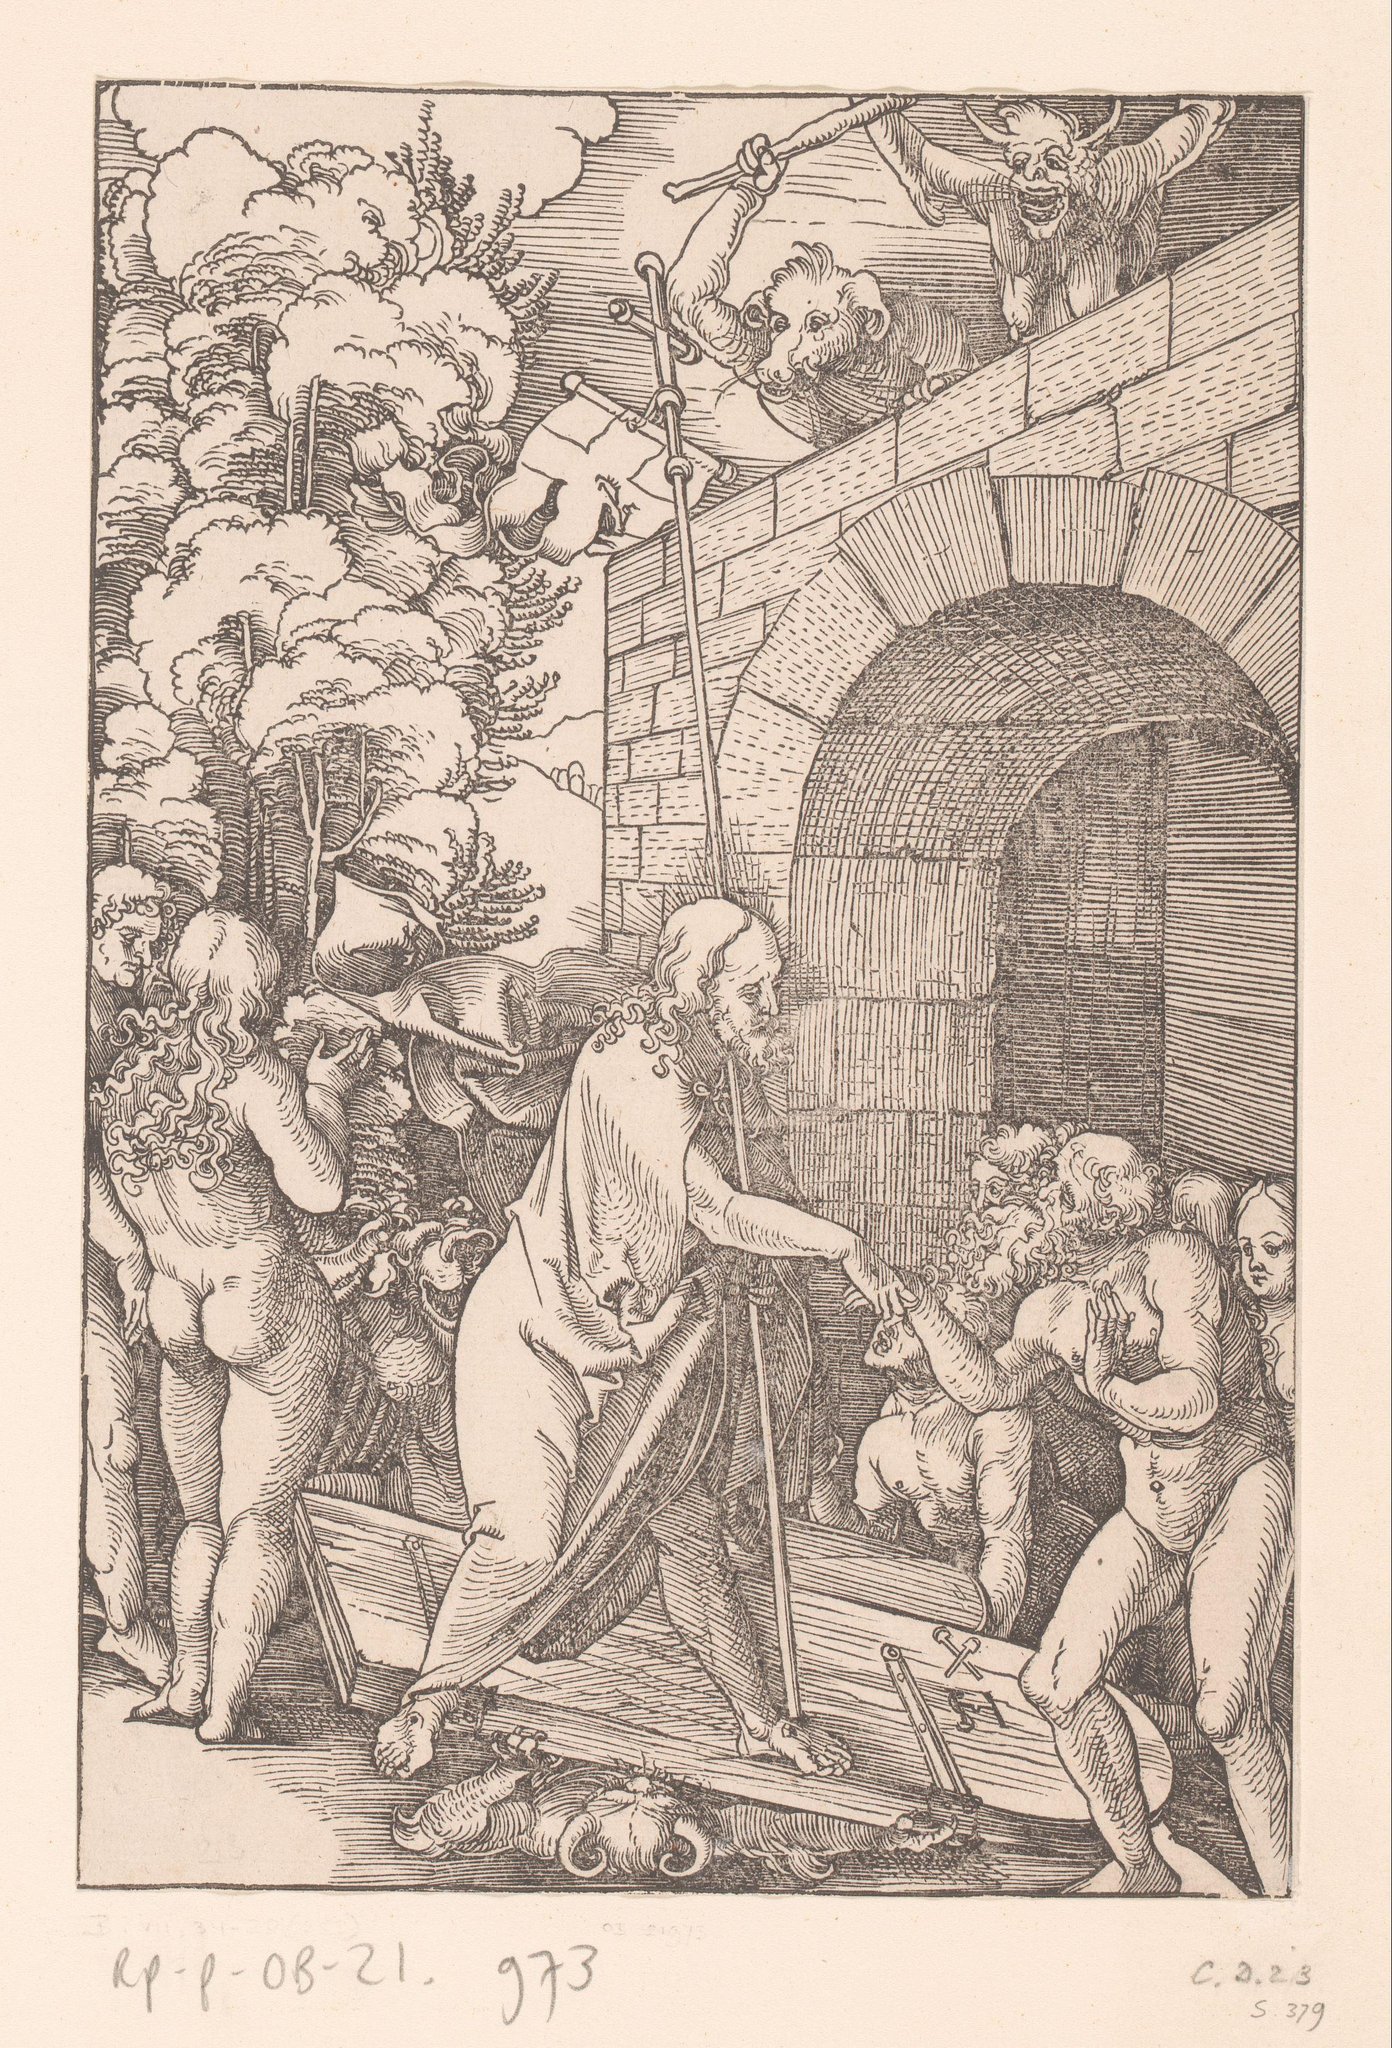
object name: print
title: Hellevaart van Christus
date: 1506-1507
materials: paper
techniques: woodcut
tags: christ in the underworld, harrowing of hell, christ in limbo, 'descensus ad inferos', 'anastasis'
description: Prent voor het eerst gebruikt in: Speculum Passionis. Neurenberg: Ulrich Pinder, 1507.